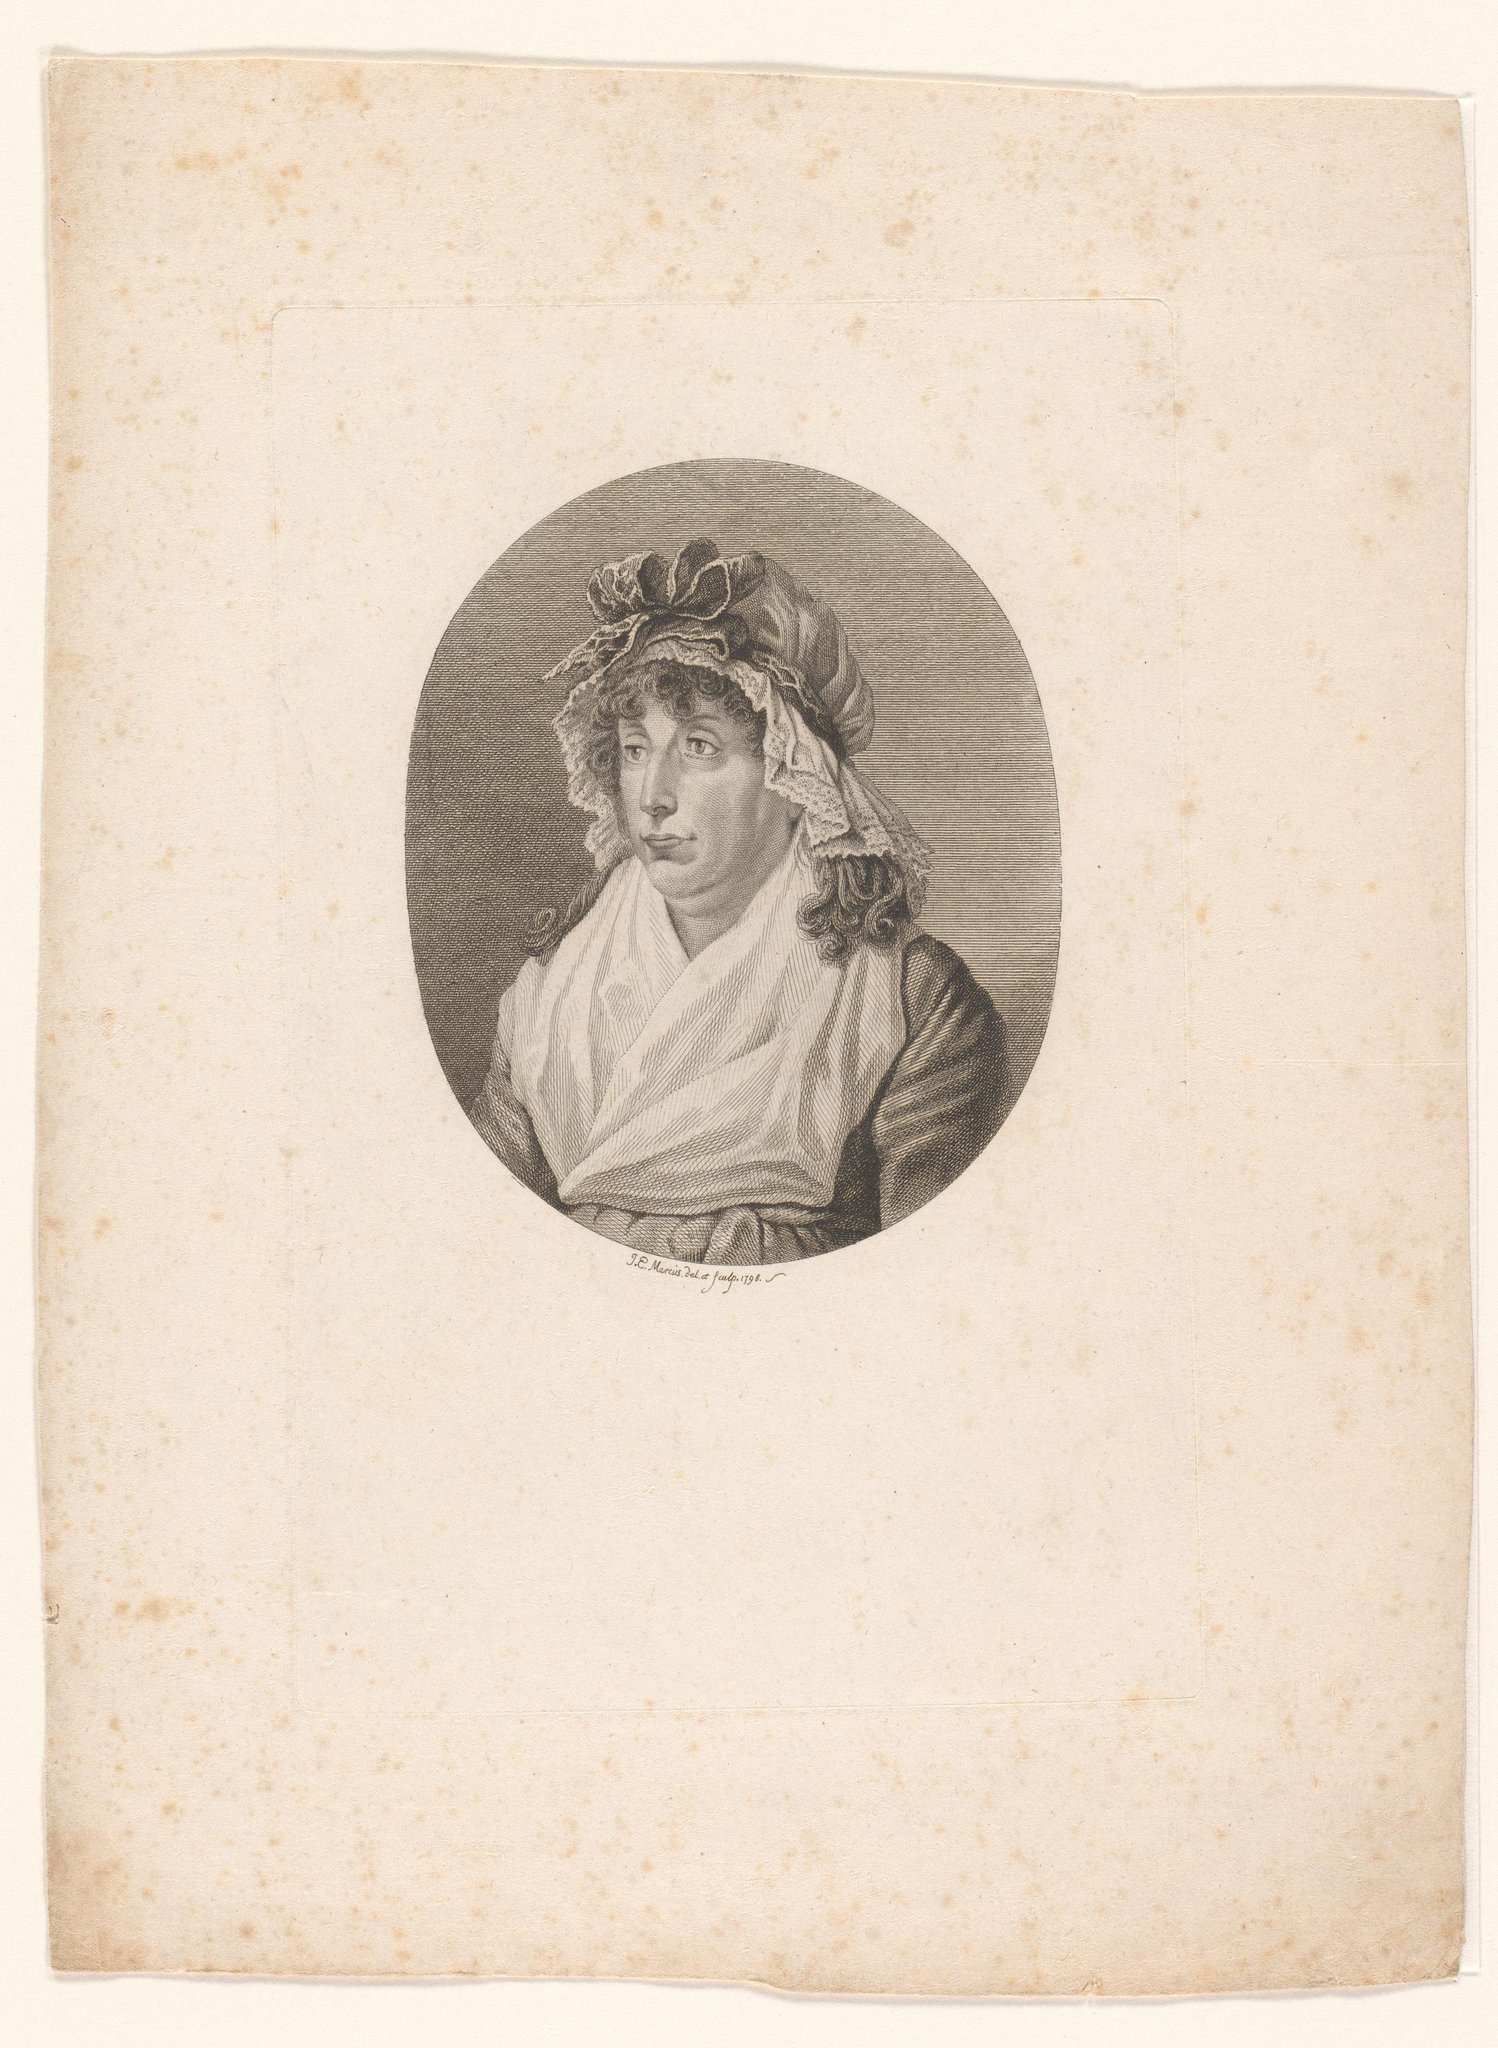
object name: print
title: Portret van Anna Maria Taunay-Scharff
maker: jacob ernst marcus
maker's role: draughtsman, print maker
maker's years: 1774-1826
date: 1798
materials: paper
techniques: engraving, etching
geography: amsterdam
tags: historical persons - bb - woman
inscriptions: date